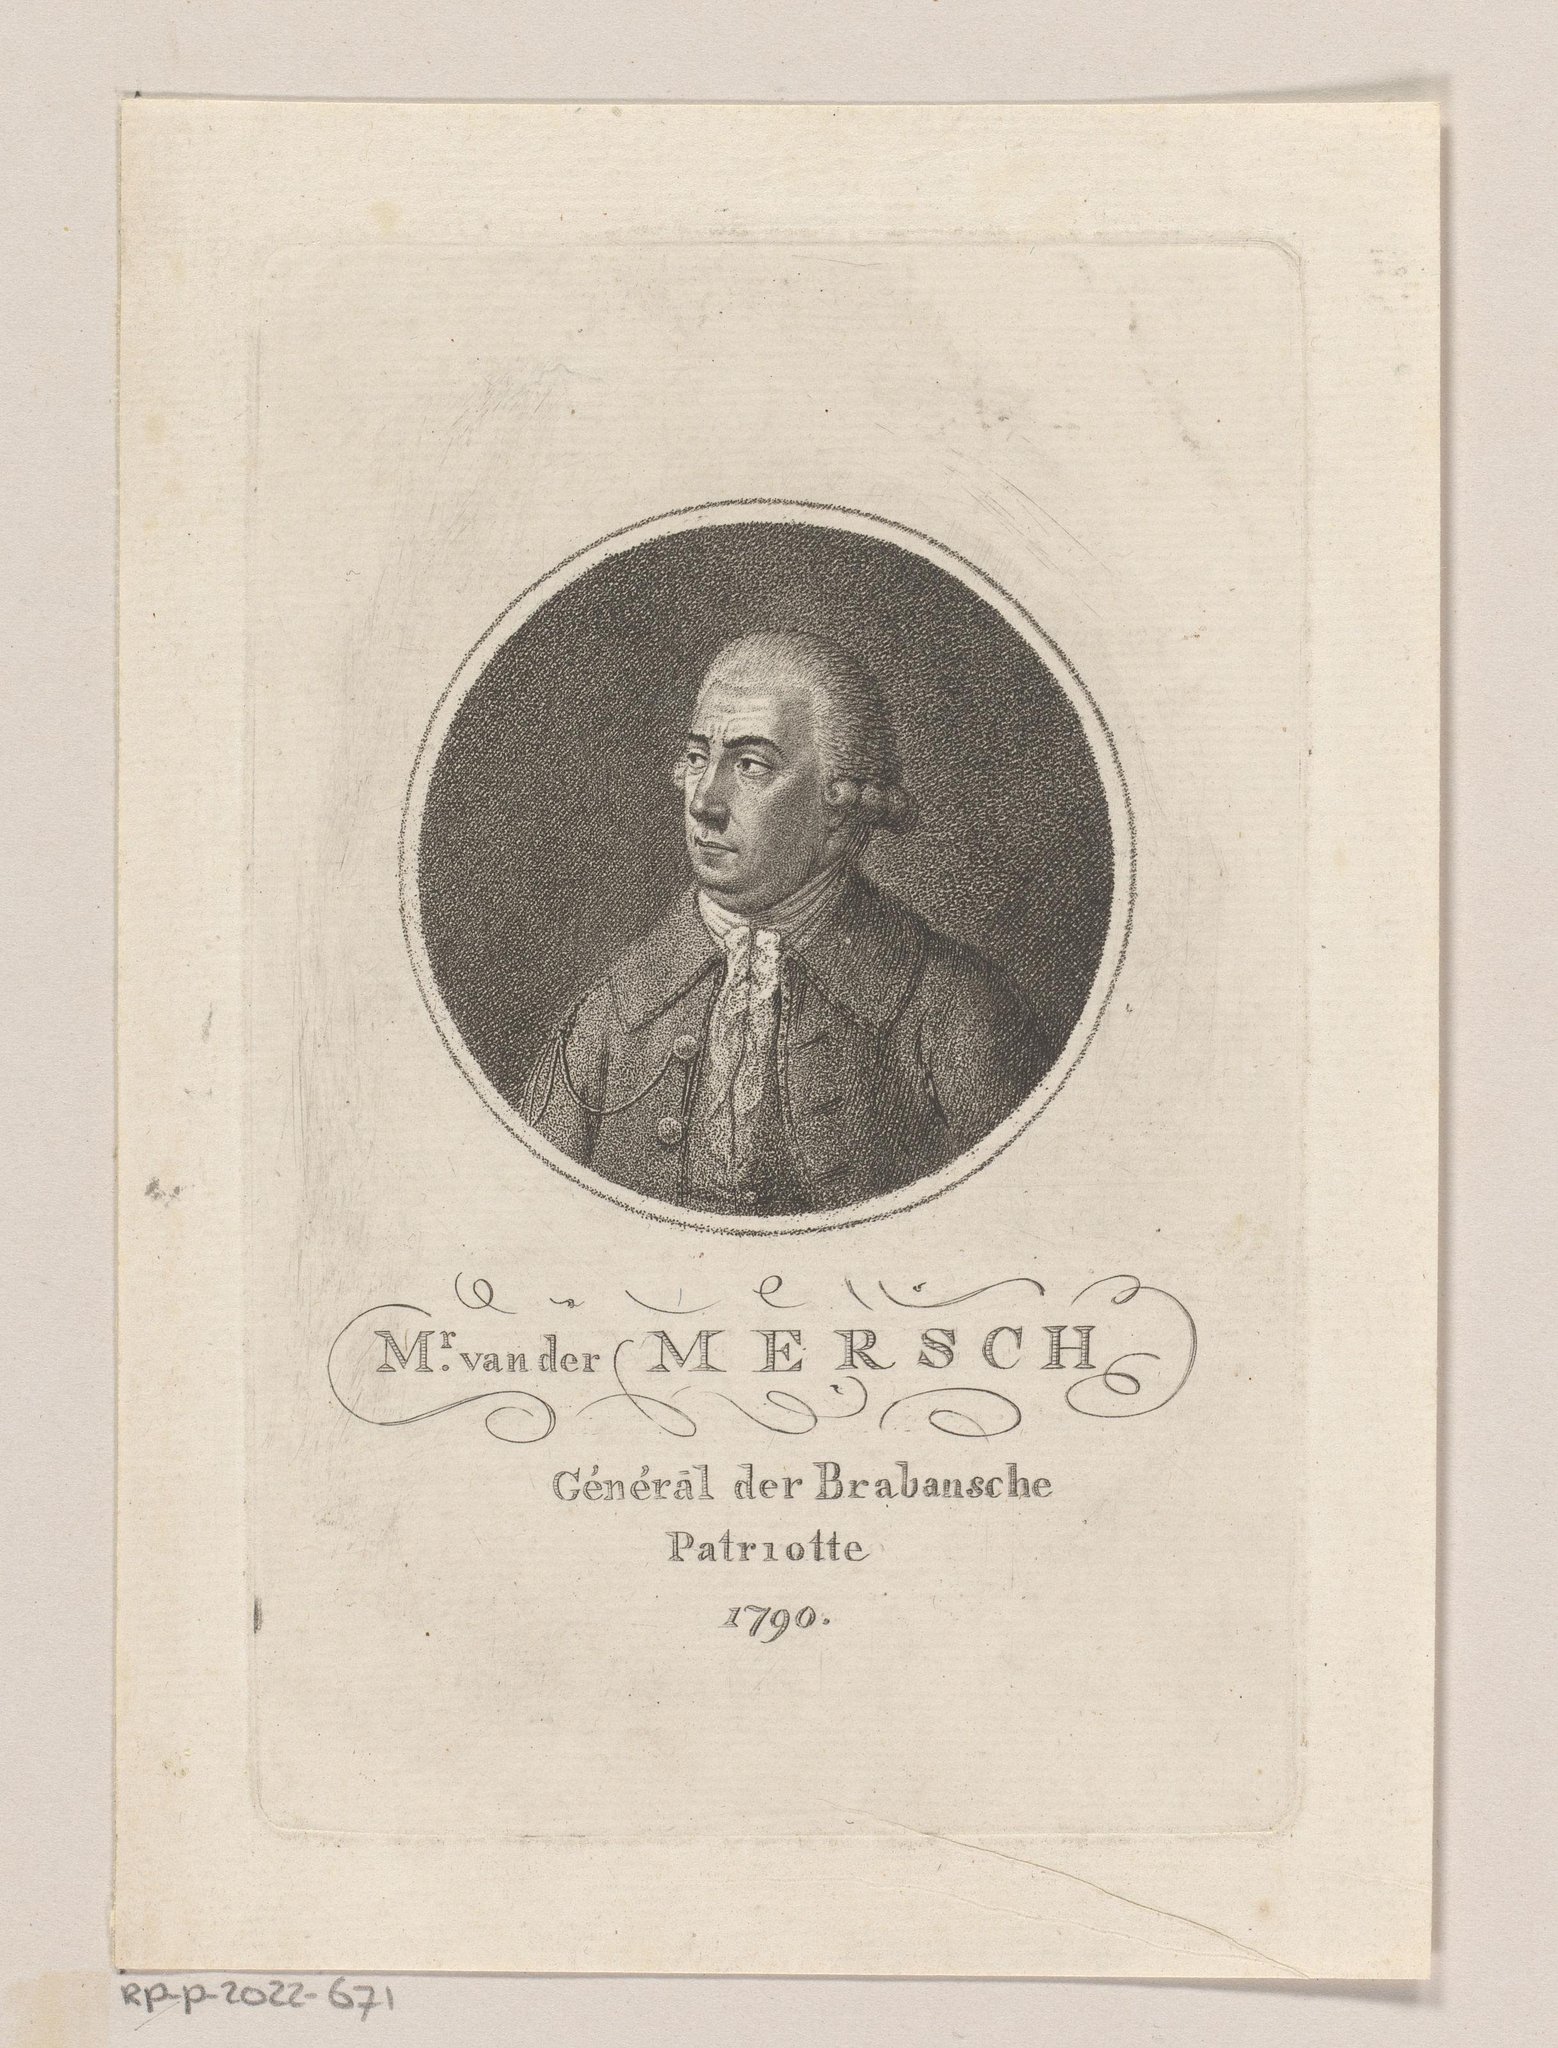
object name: print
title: Mr. van der Mersch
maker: Anonymous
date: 1790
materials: paper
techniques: etching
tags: commander-in-chief, general, marshal, historical persons